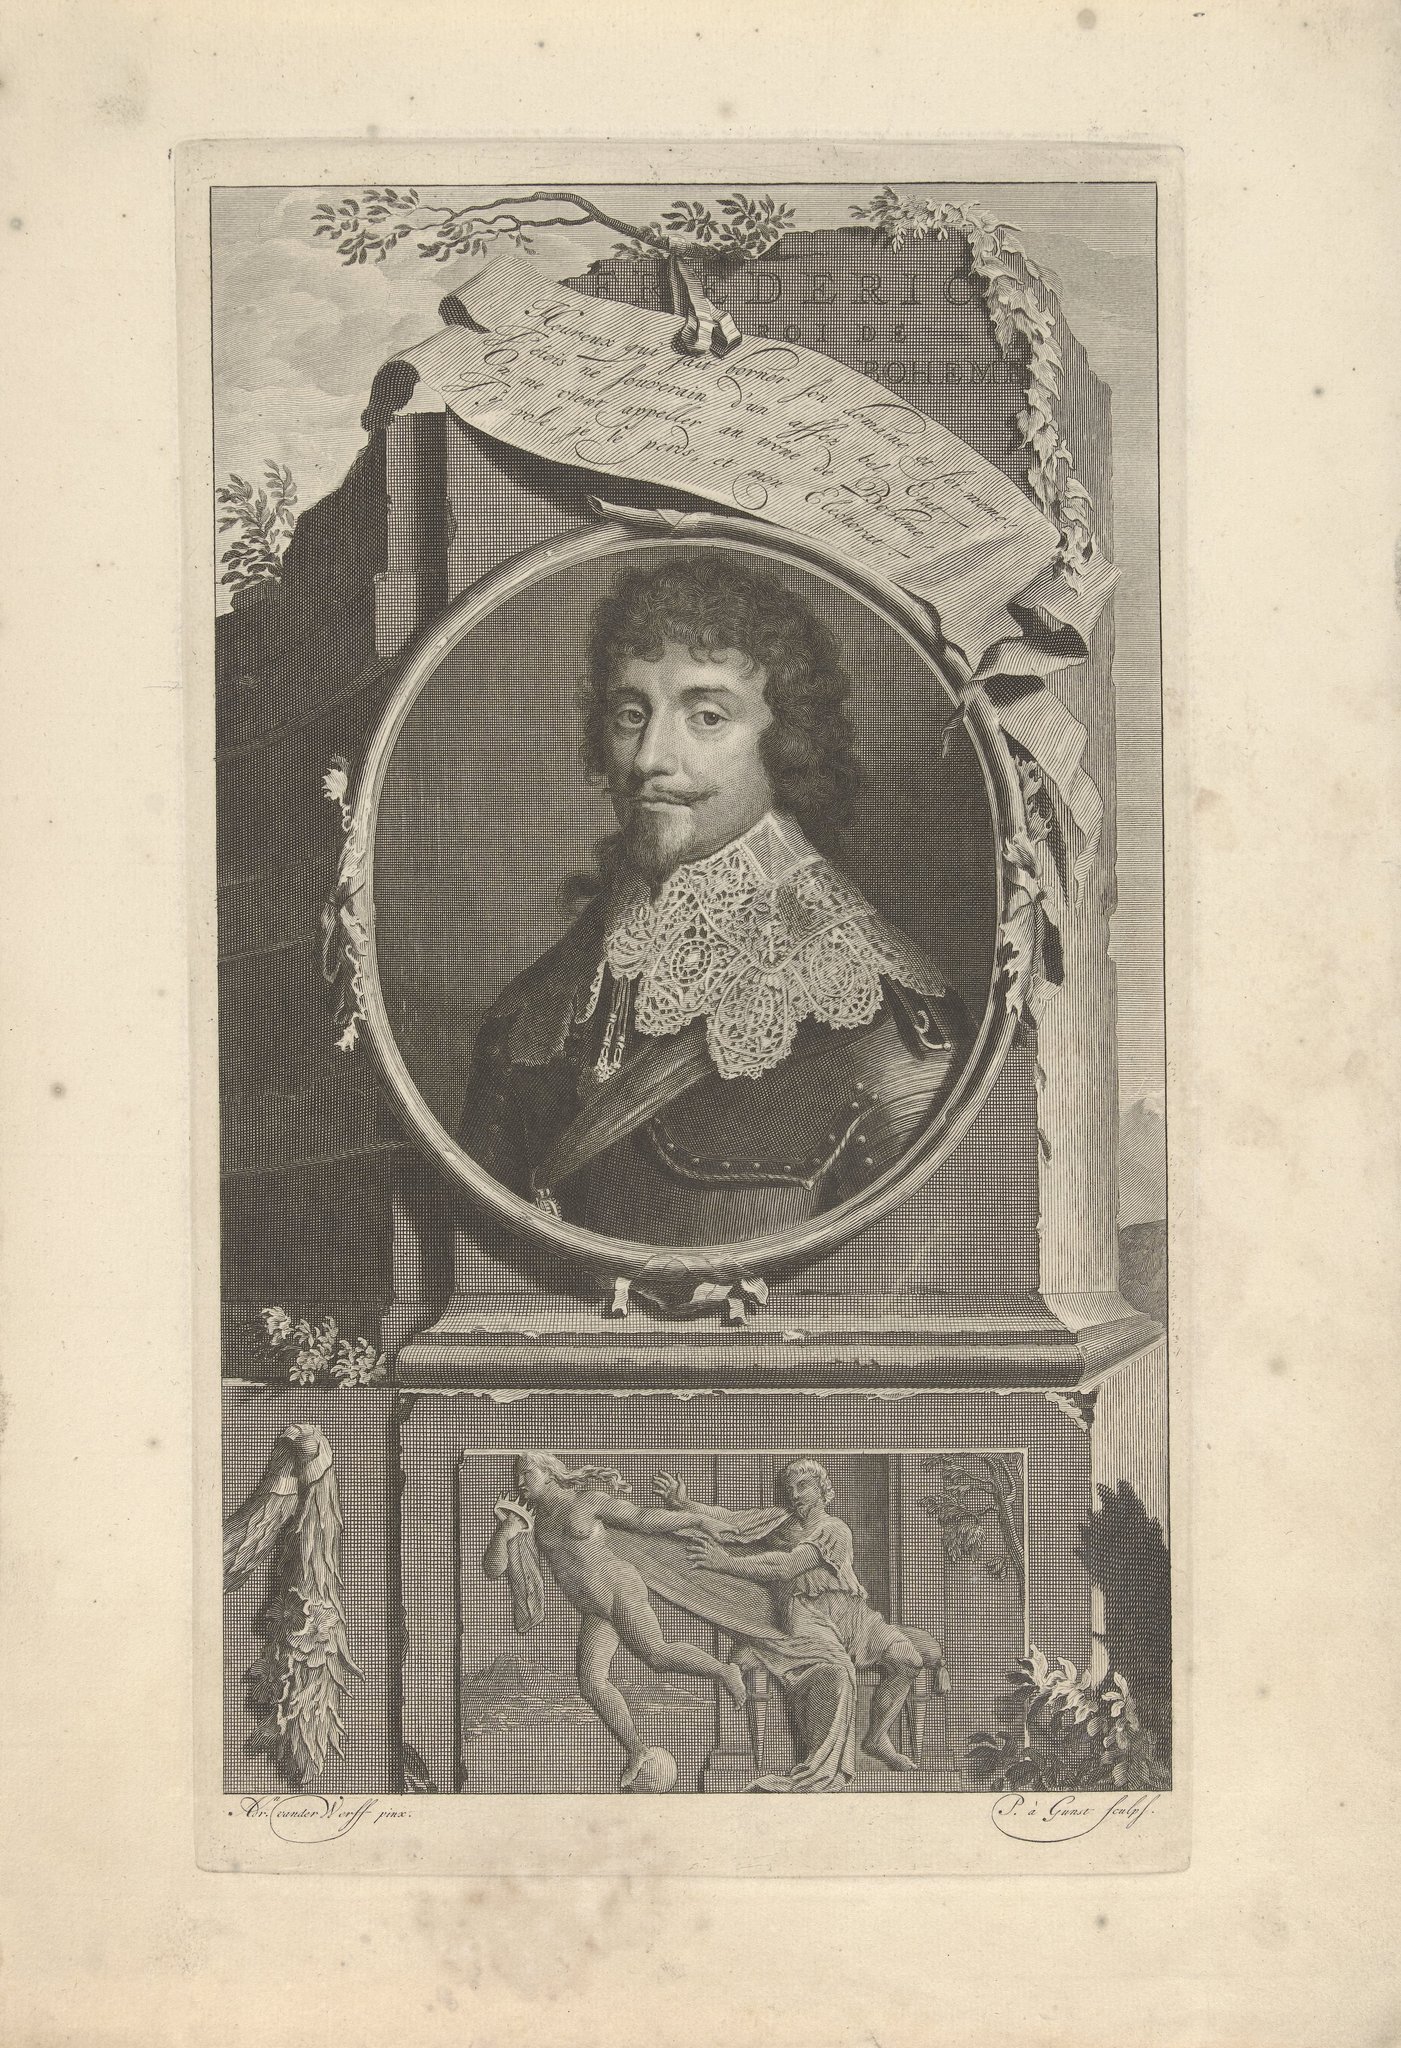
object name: print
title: Gedenkteken voor Joannes de Fremery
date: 1819-1821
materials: paper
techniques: engraving, etching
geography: the hague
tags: middelburg, symbols of last judgement, torch (+ extinguishing; extinguished light, lamp, candle), faith, 'fides'; 'fede', 'fede catholica', 'fede christiana', 'fede christiana catholica' (ripa) ~ one of the three theological virtues, the sower ~ parable of christ (matthew 13:3-9; mark 4:3-9; luke 8:5-8), hourglass, mourning the dead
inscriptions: collector's mark: Lugt 2228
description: Een gedenkteken voor Joannes de Fremery, hoogleraar en predikant te Middelburg, die in 1819 overleed. Op de zuil is het portret van De Fremery aangebracht en de basis toont een plaquette met een achtregelige tekst in het Nederlands. Het monument wordt geflankeerd door het Geloof met een boek op haar schoot en in haar hand een schrijfveer en door de treurende Godsdienst. Een putto toont de beeltenis van een kerkinterieur. Op de grond liggen de gedoofde en gebroken toorts en een zandloper ten teken van de dood. Links op de achtergrond staan twee figuren tussen korenschoven, waarvan één omhoog wijst naar het zonlicht. De bijeengebonden schoven duiden op het Laatste Oordeel, waarbij God het zaad of zijn Woord dat in goede grond is gevallen, naar de gelijkenis van de zaaier, zal oogsten.